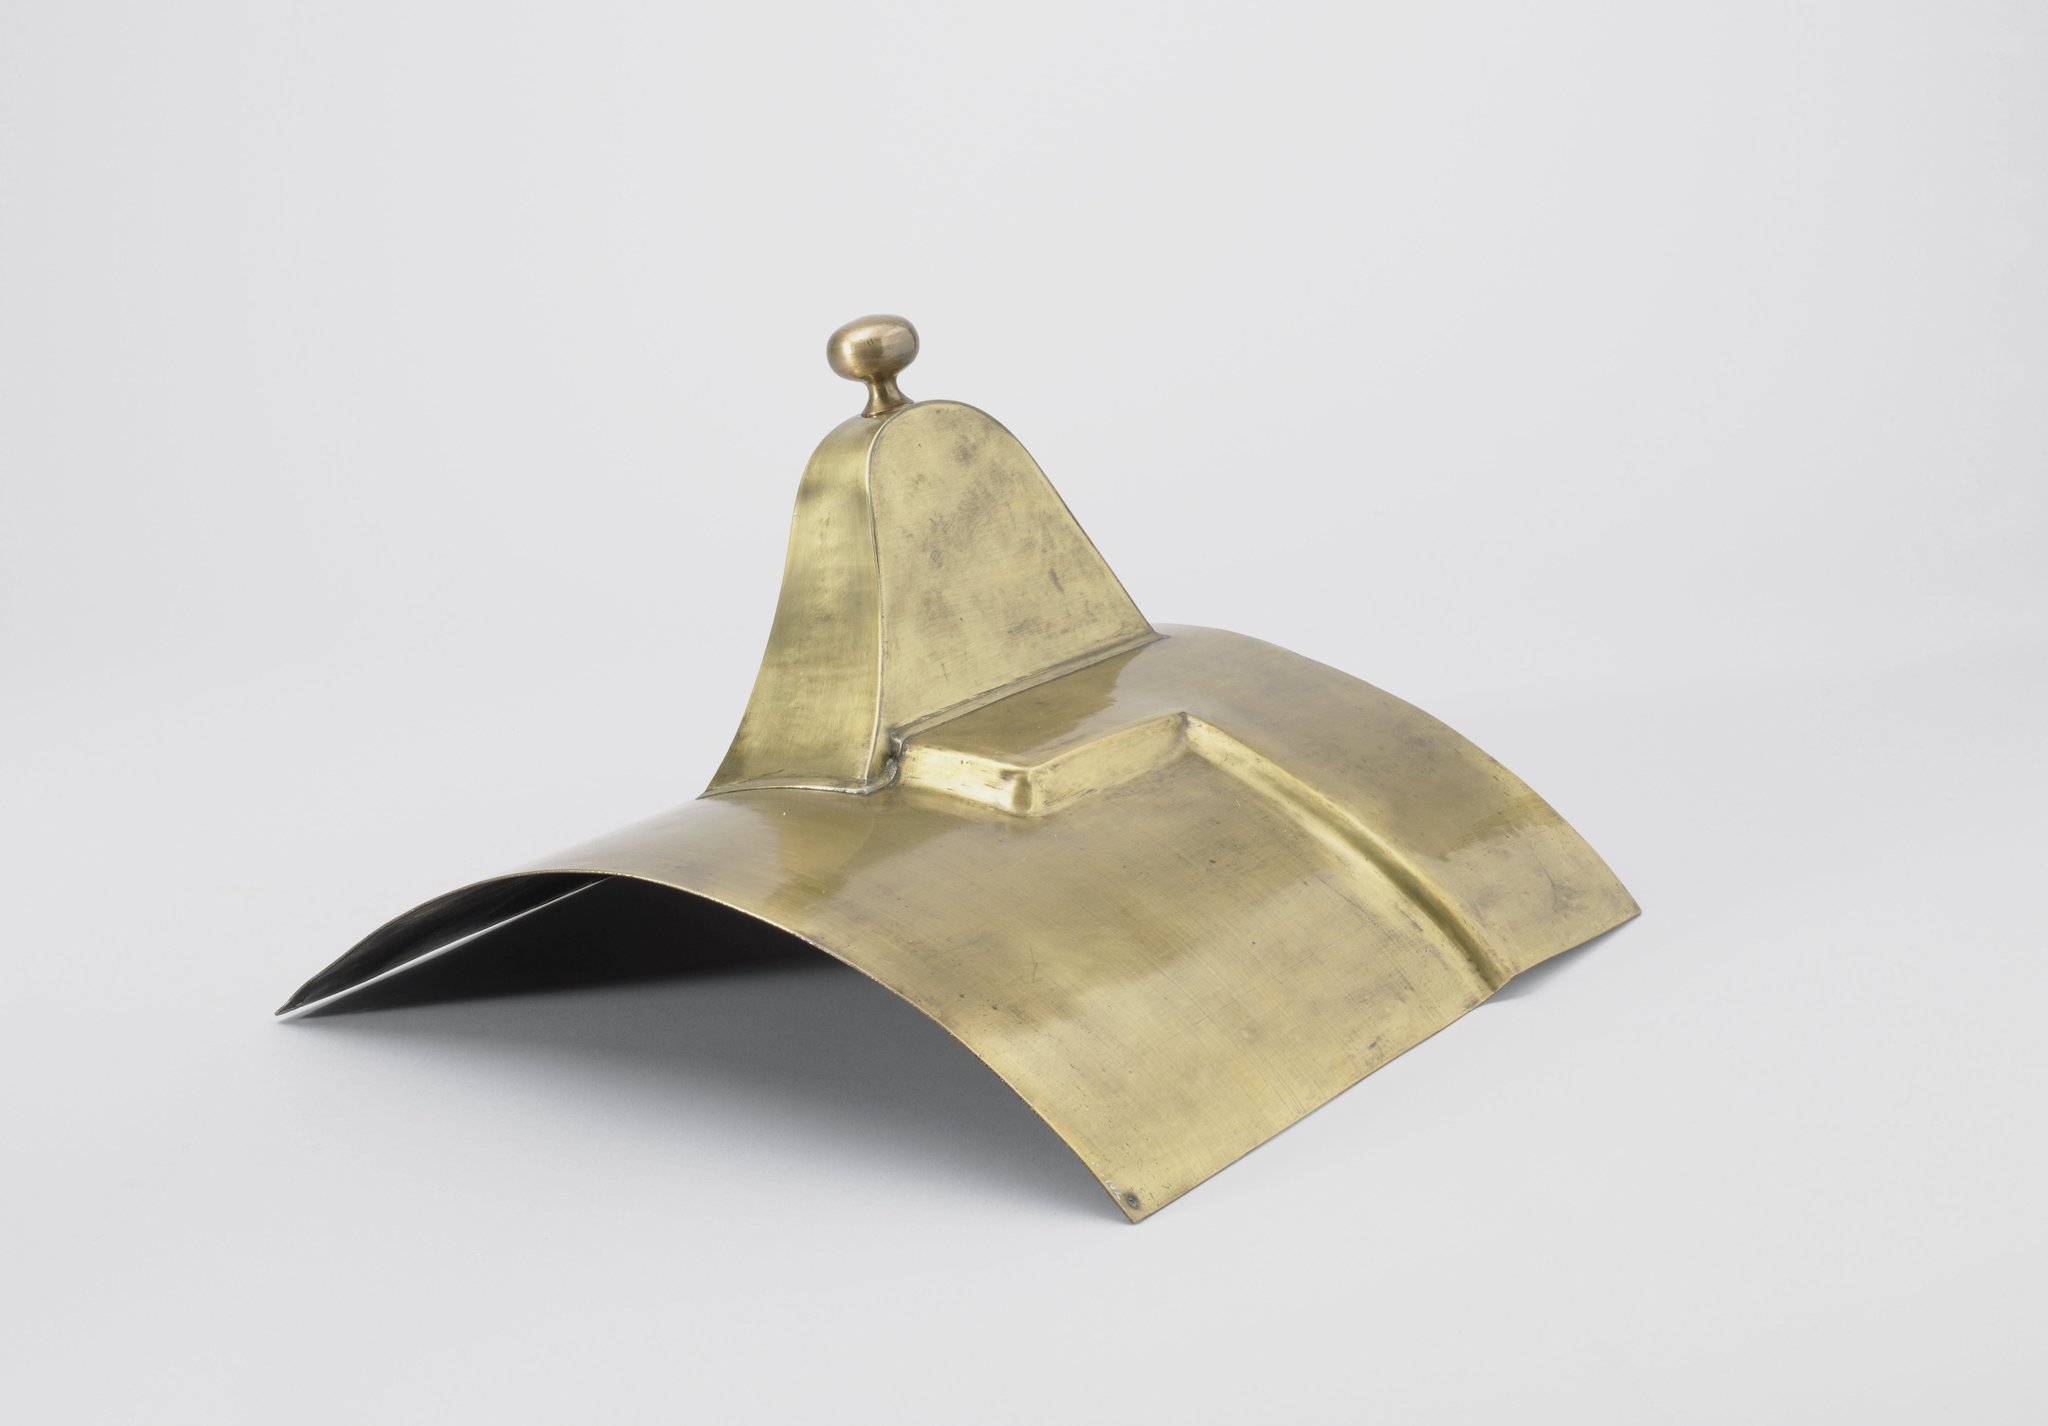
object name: demonstration model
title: Model of a Lock Cover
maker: Anonymous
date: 1825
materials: brass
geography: netherlands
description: Dit model voor zinken kanonslotdeksels, ter vervanging van de platloden voor geschut met slot, werd in 1825 door P. Schuijt naar Den Haag gestuurd. Aan het fregat Rupel en de korvet Arend zouden in 1825 koperen slotdeksels verstrekt worden, maar om onbekende redenen ging dit niet door. In 1830 stelde Sesseler voor ze van lood te laten vervaardigen. In 1832 werden in Vlissingen zinken deksels besteld. Het model werd daarna in de modellenverzameling geplaatst.